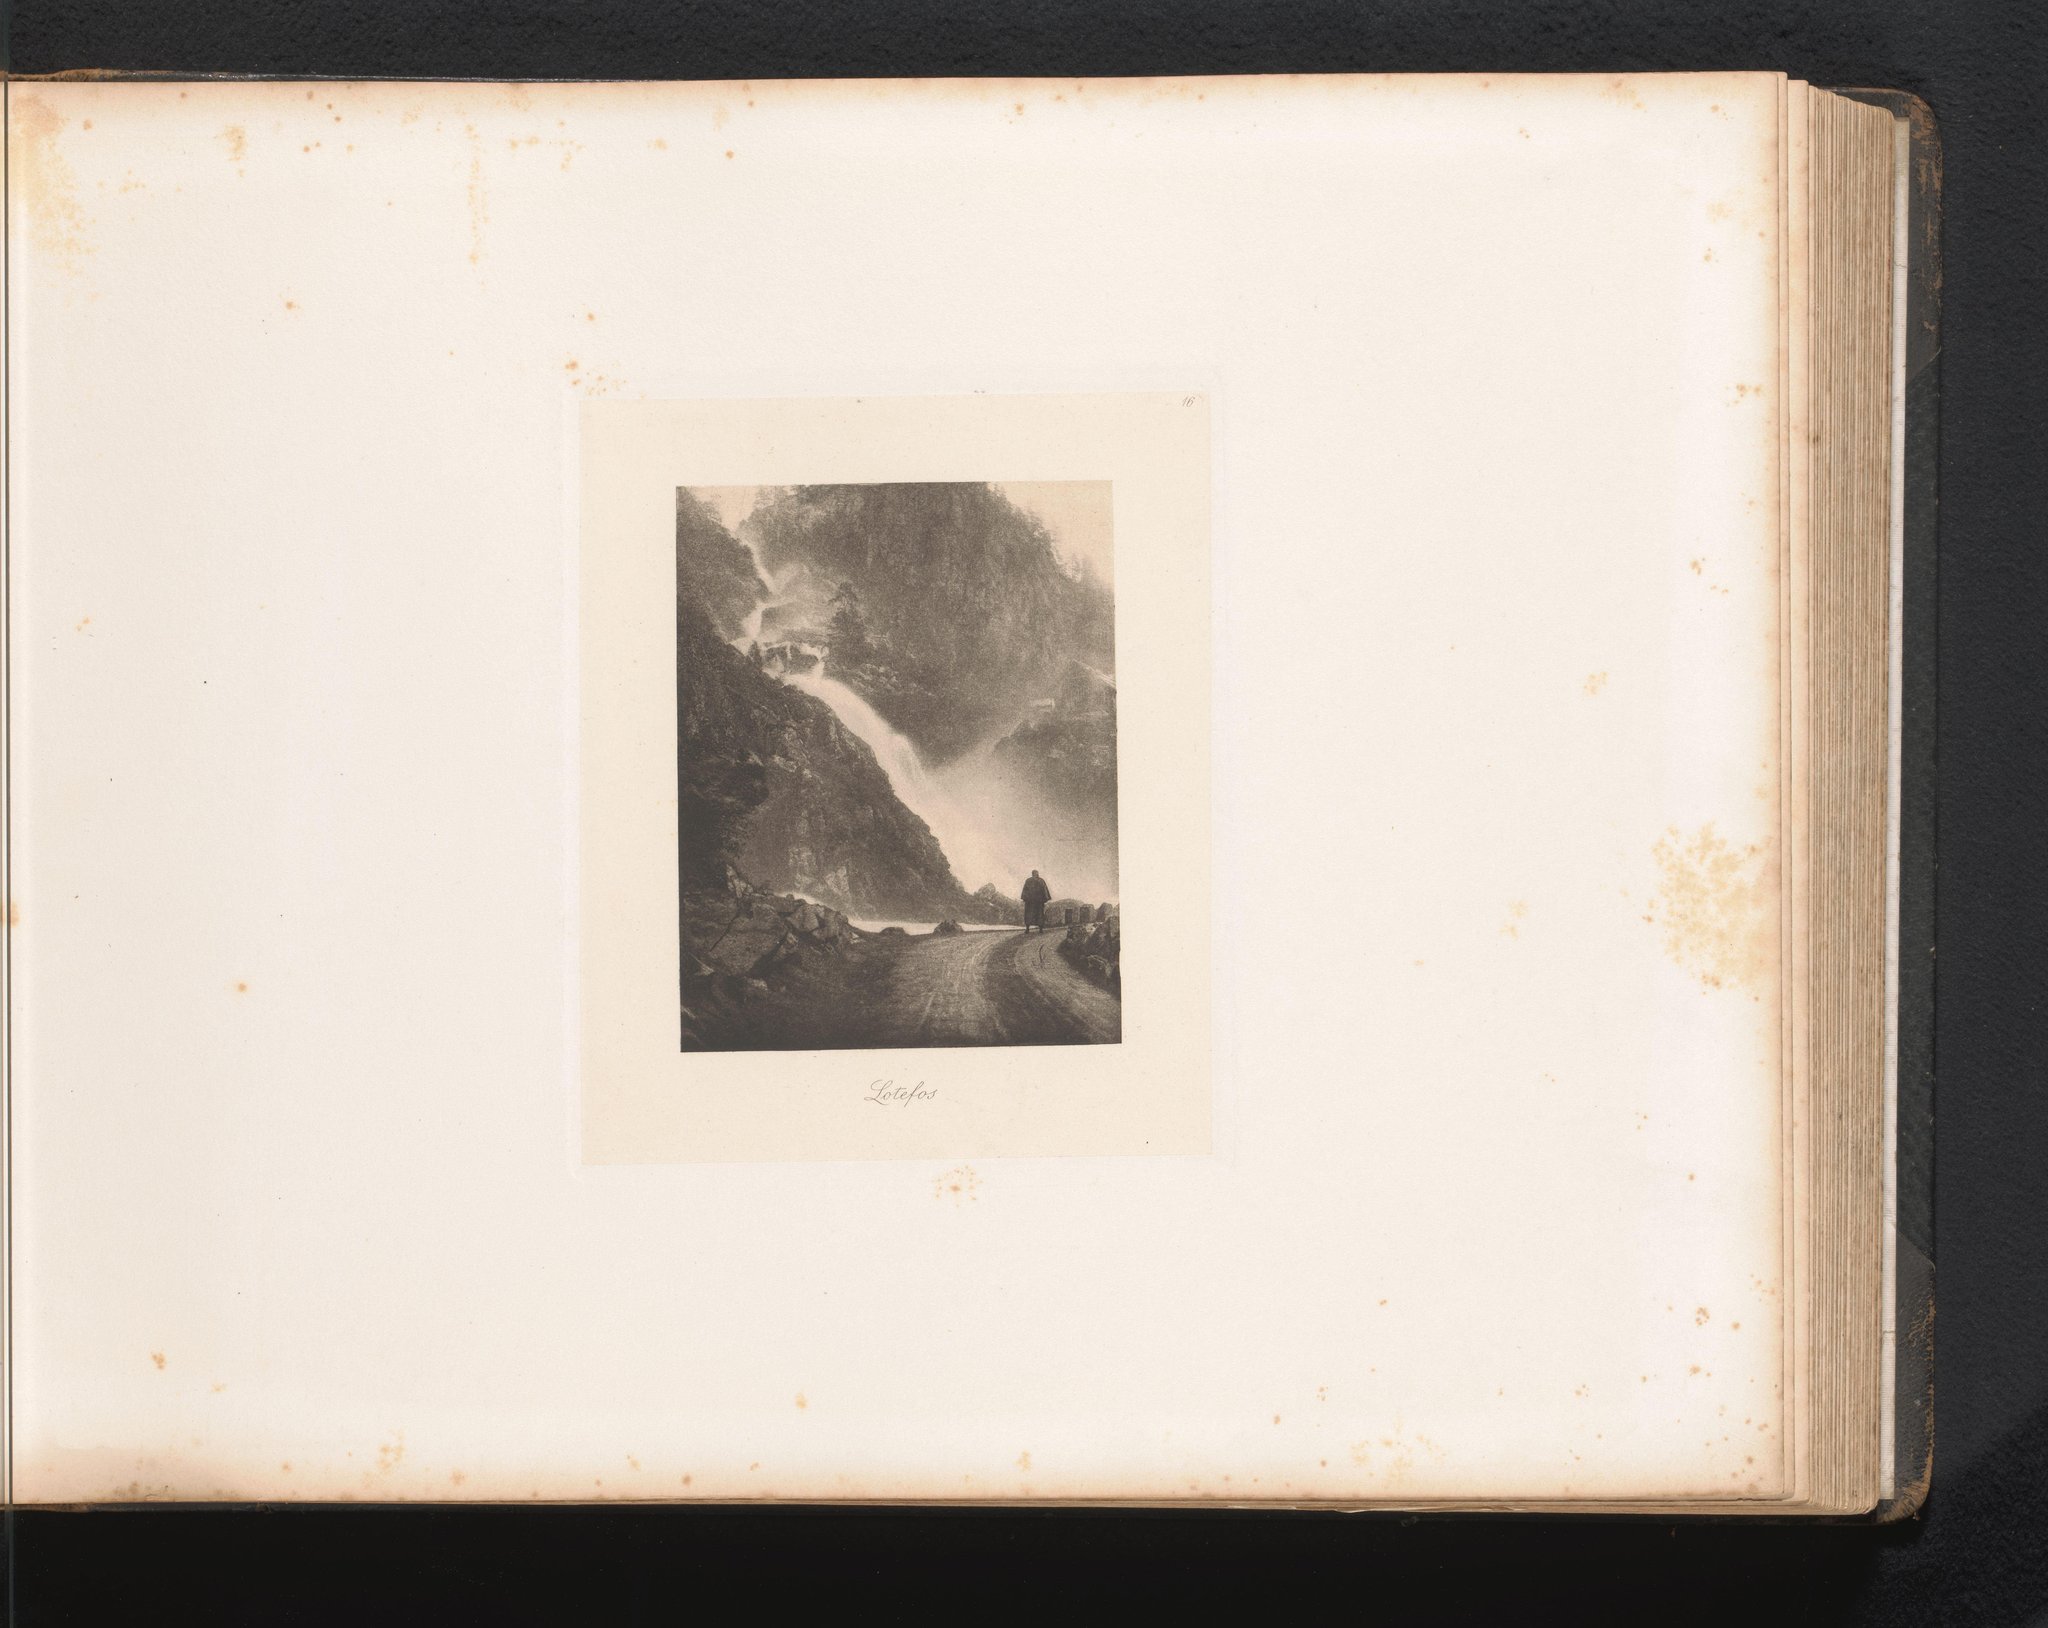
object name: photomechanical print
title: Gezicht op de Låtefossen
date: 1888-1893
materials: paper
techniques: photograph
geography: hordaland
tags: waterfall (+ landscape with figures, staffage)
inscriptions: number: ‘16’